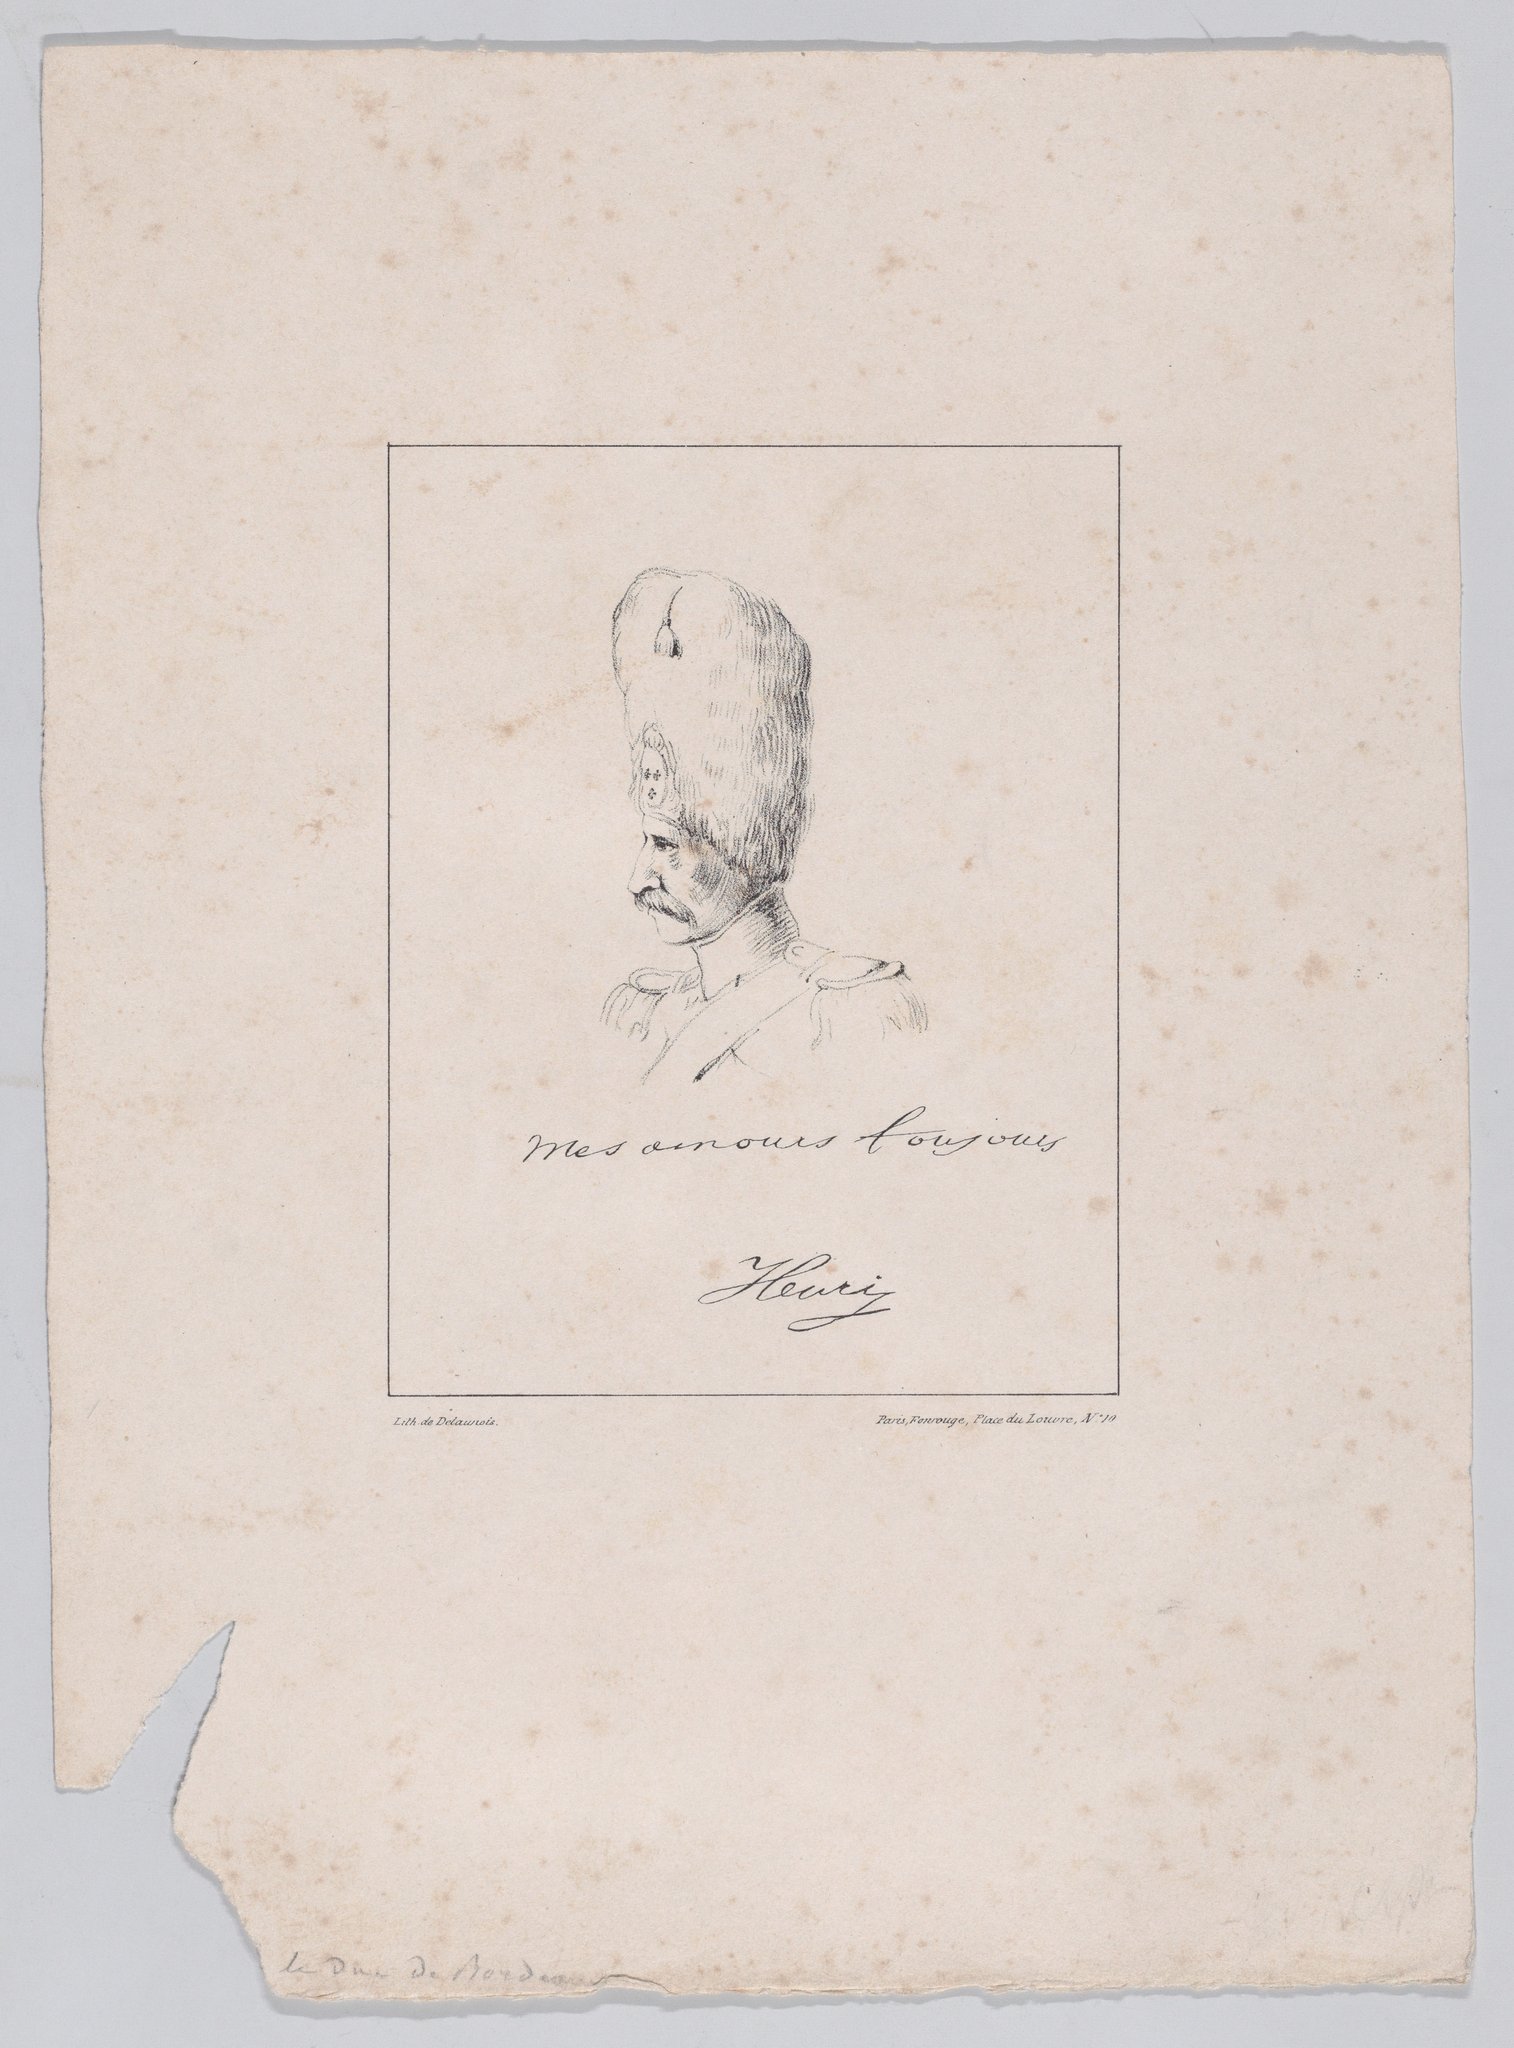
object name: print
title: Profile bust of an officer in a bear fur hat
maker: delaunois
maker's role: artist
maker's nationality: french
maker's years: 1800-1900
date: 1830-1840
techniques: lithograph